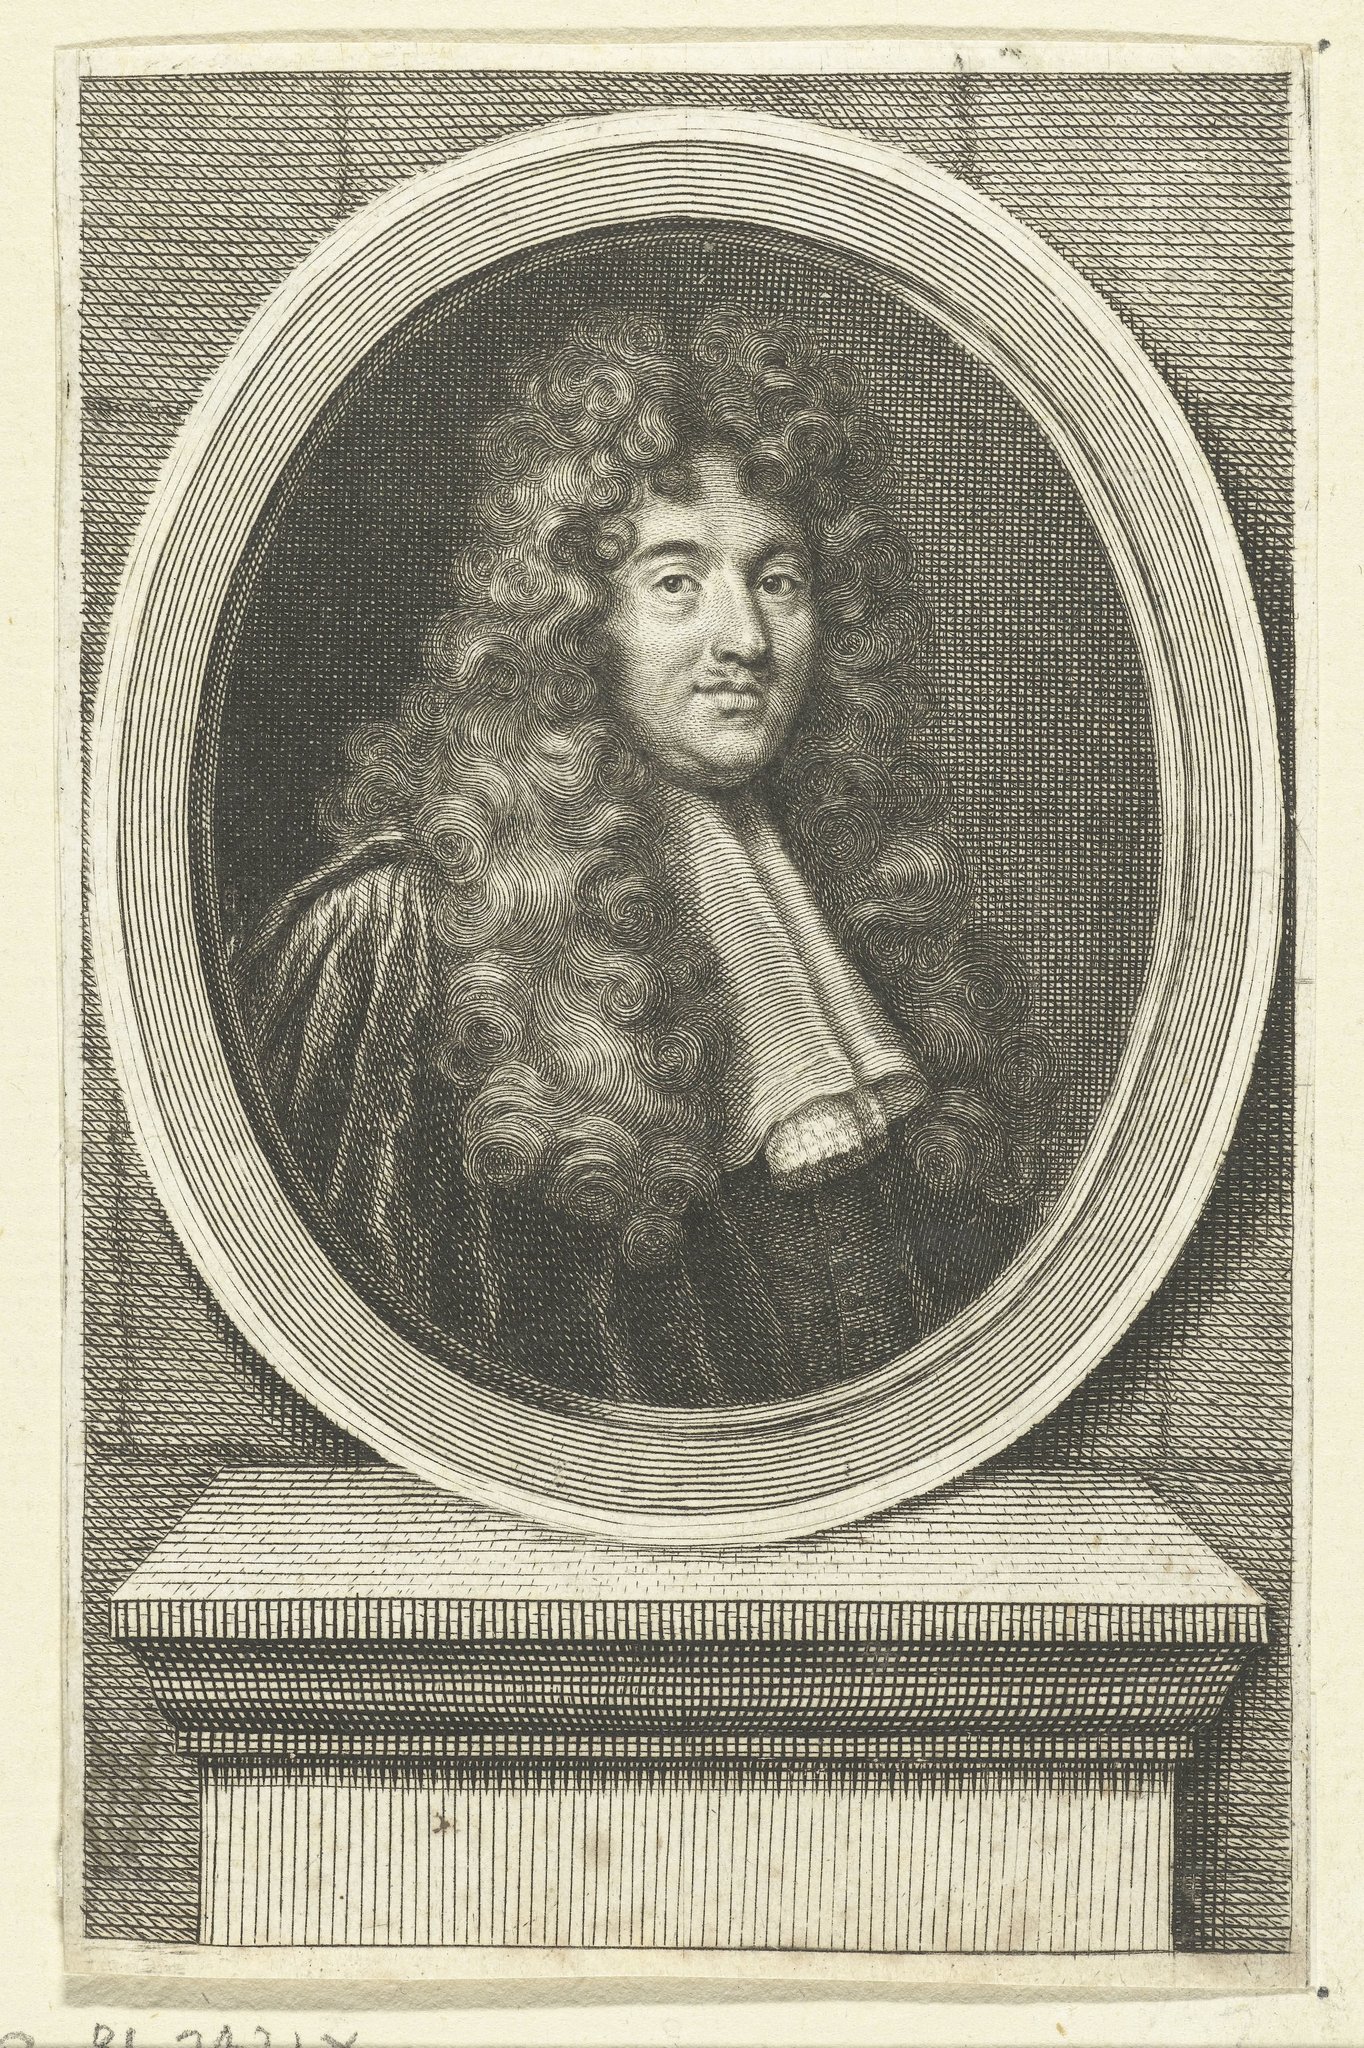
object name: print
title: Portret van een man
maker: gerard edelinck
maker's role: print maker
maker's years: 1640-1707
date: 1666-1707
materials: paper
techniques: engraving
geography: paris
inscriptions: collector's mark: Lugt 240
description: Busteportret van een niet geïdentificeerde man, afgebeeld in ovale omlijsting staand op console.